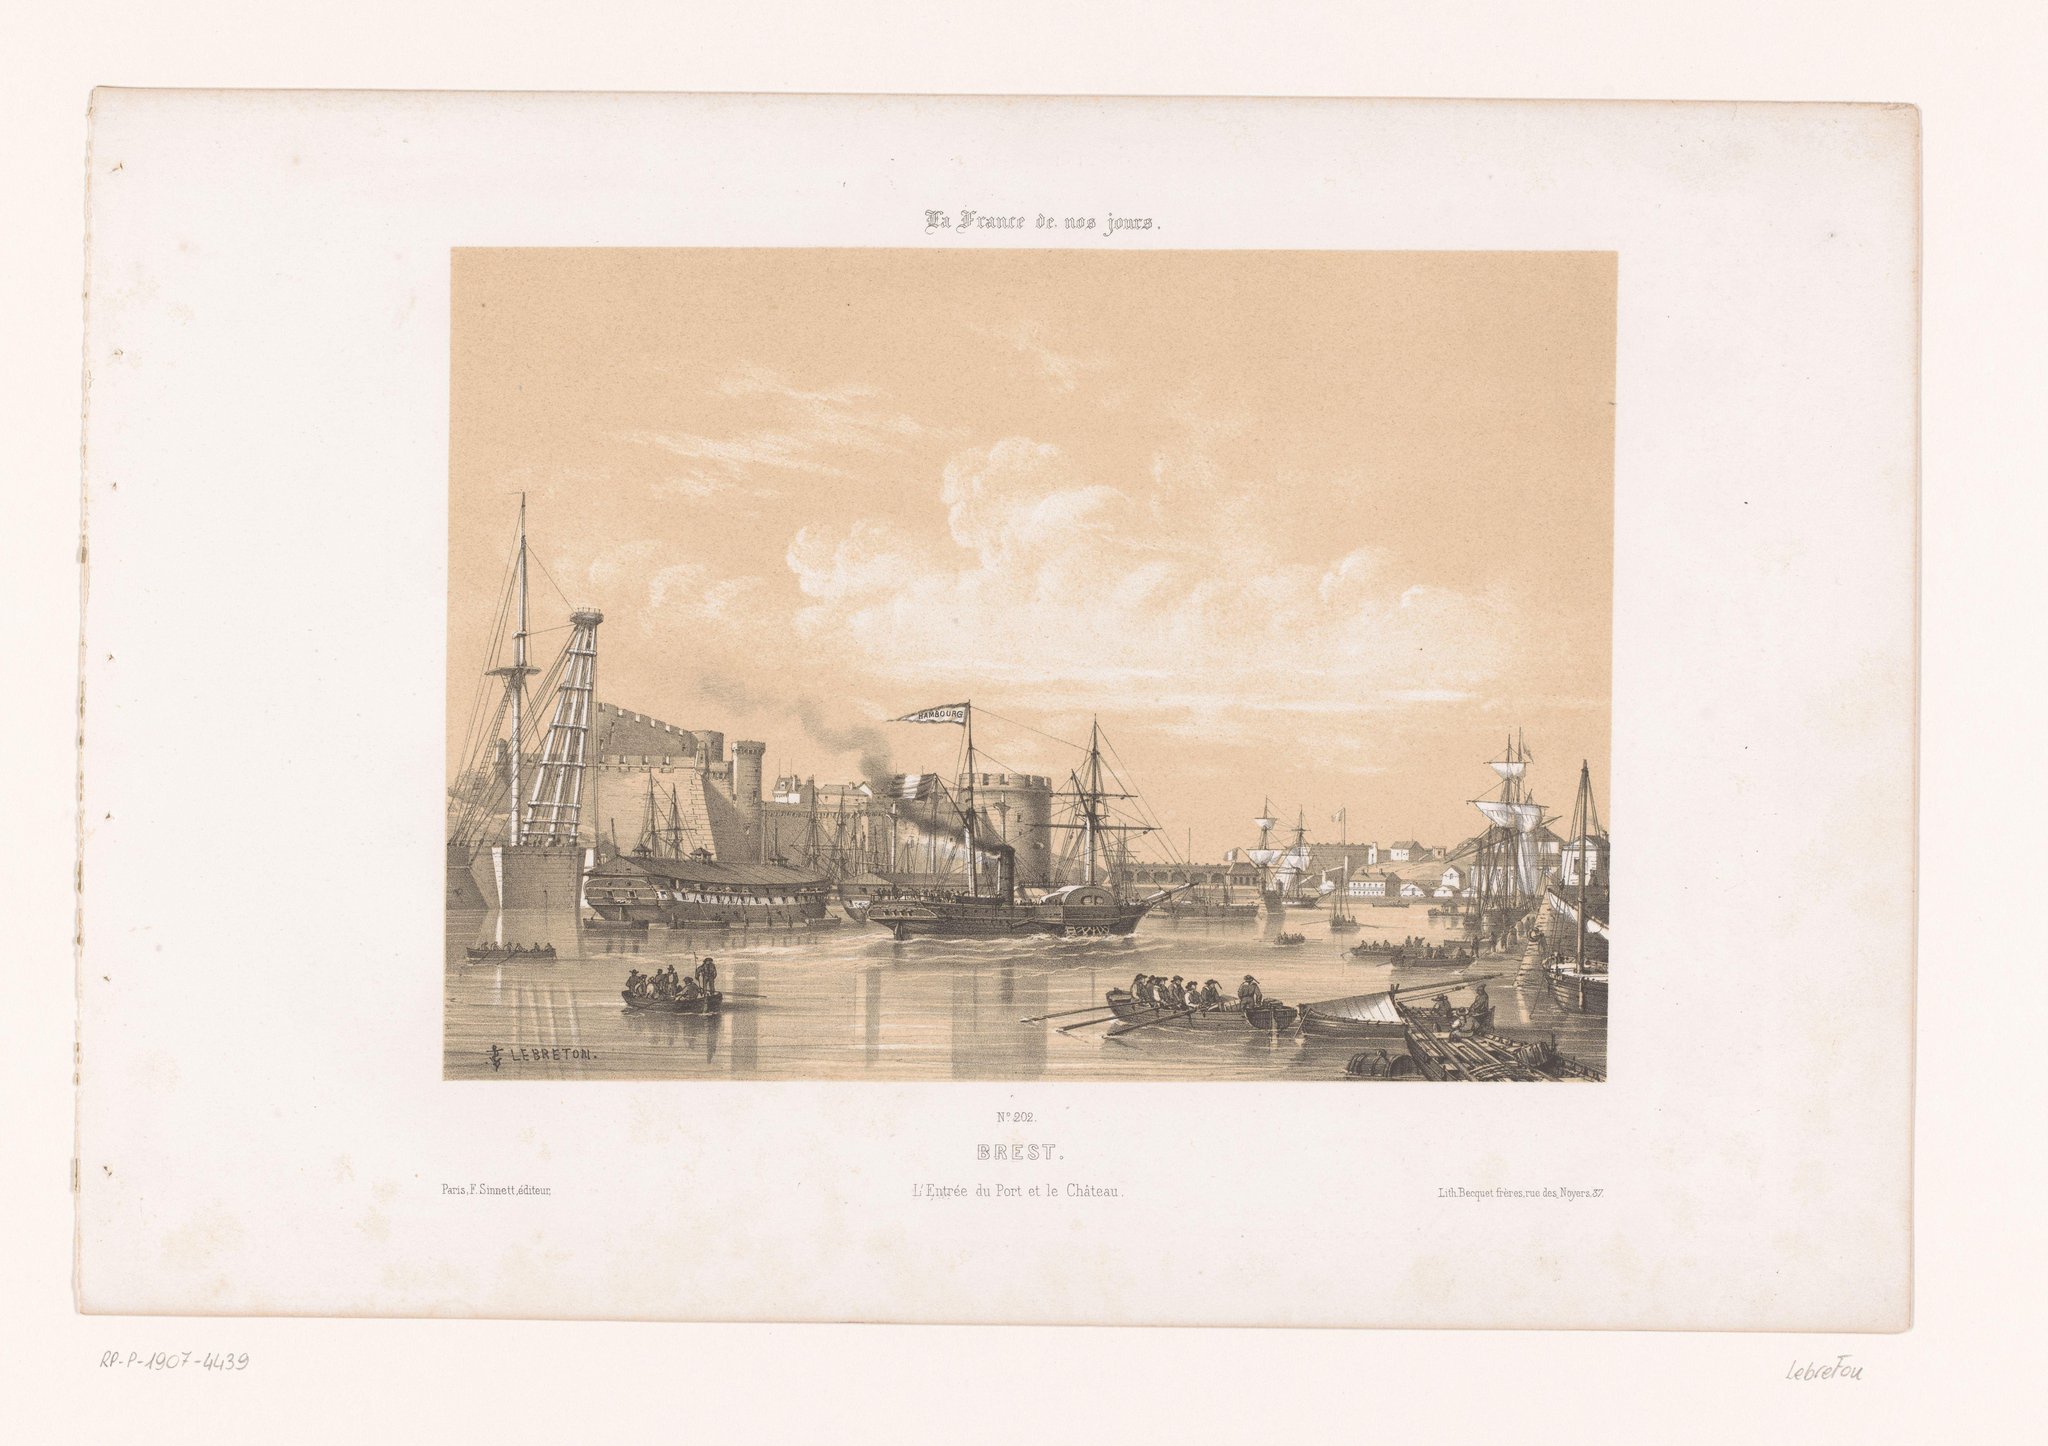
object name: print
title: La France de nos jours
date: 1855-1859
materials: paper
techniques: tone lithography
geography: paris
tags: harbour, castle, ships (in general), rowing-boat, canoe, etc.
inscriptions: collector's mark: Lugt 2228a